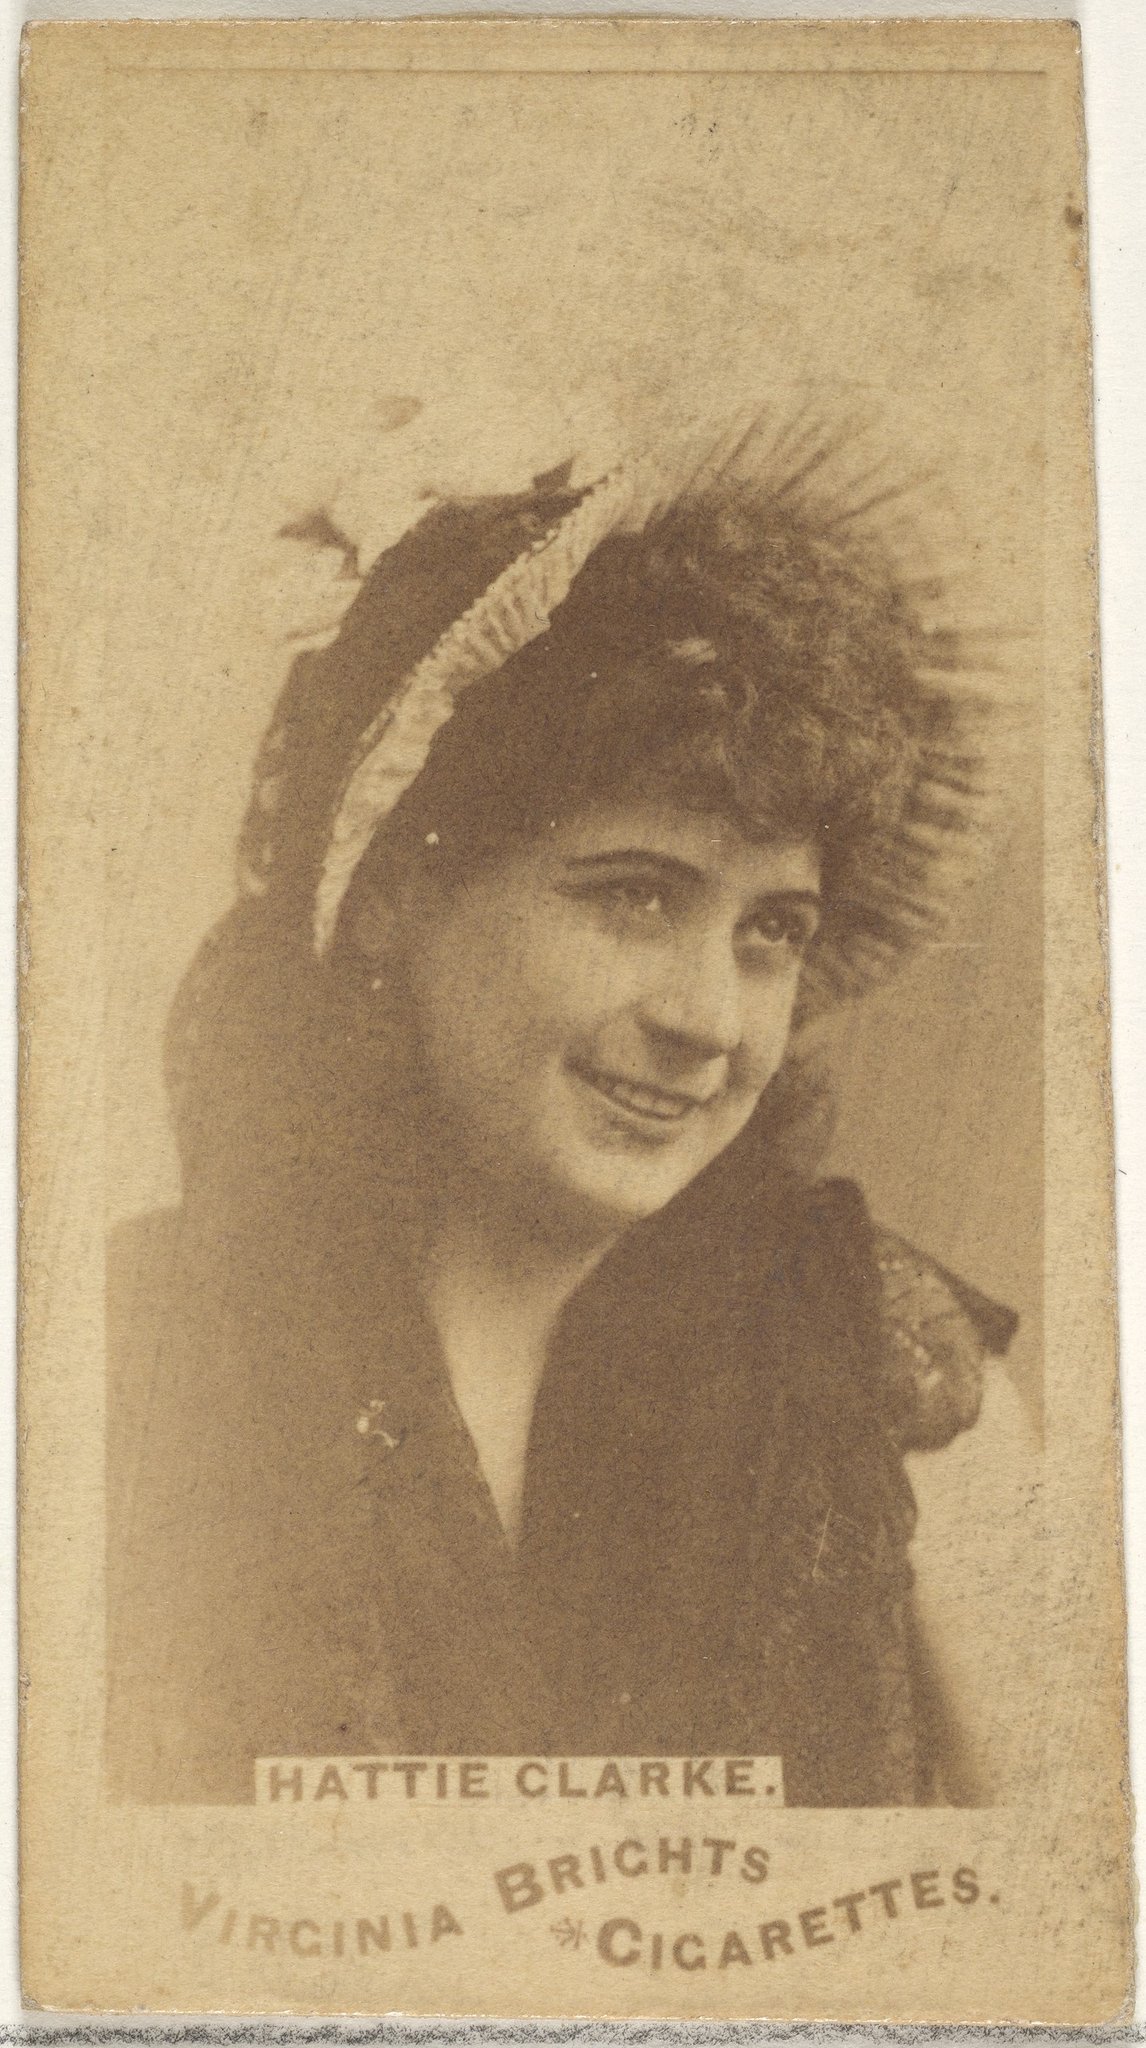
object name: photograph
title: Hattie Clarke, from the Actors and Actresses series (N45, Type 1) for Virginia Brights Cigarettes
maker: allen & ginter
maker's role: publisher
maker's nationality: american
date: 1888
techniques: albumen silver print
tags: portraits,women,actresses